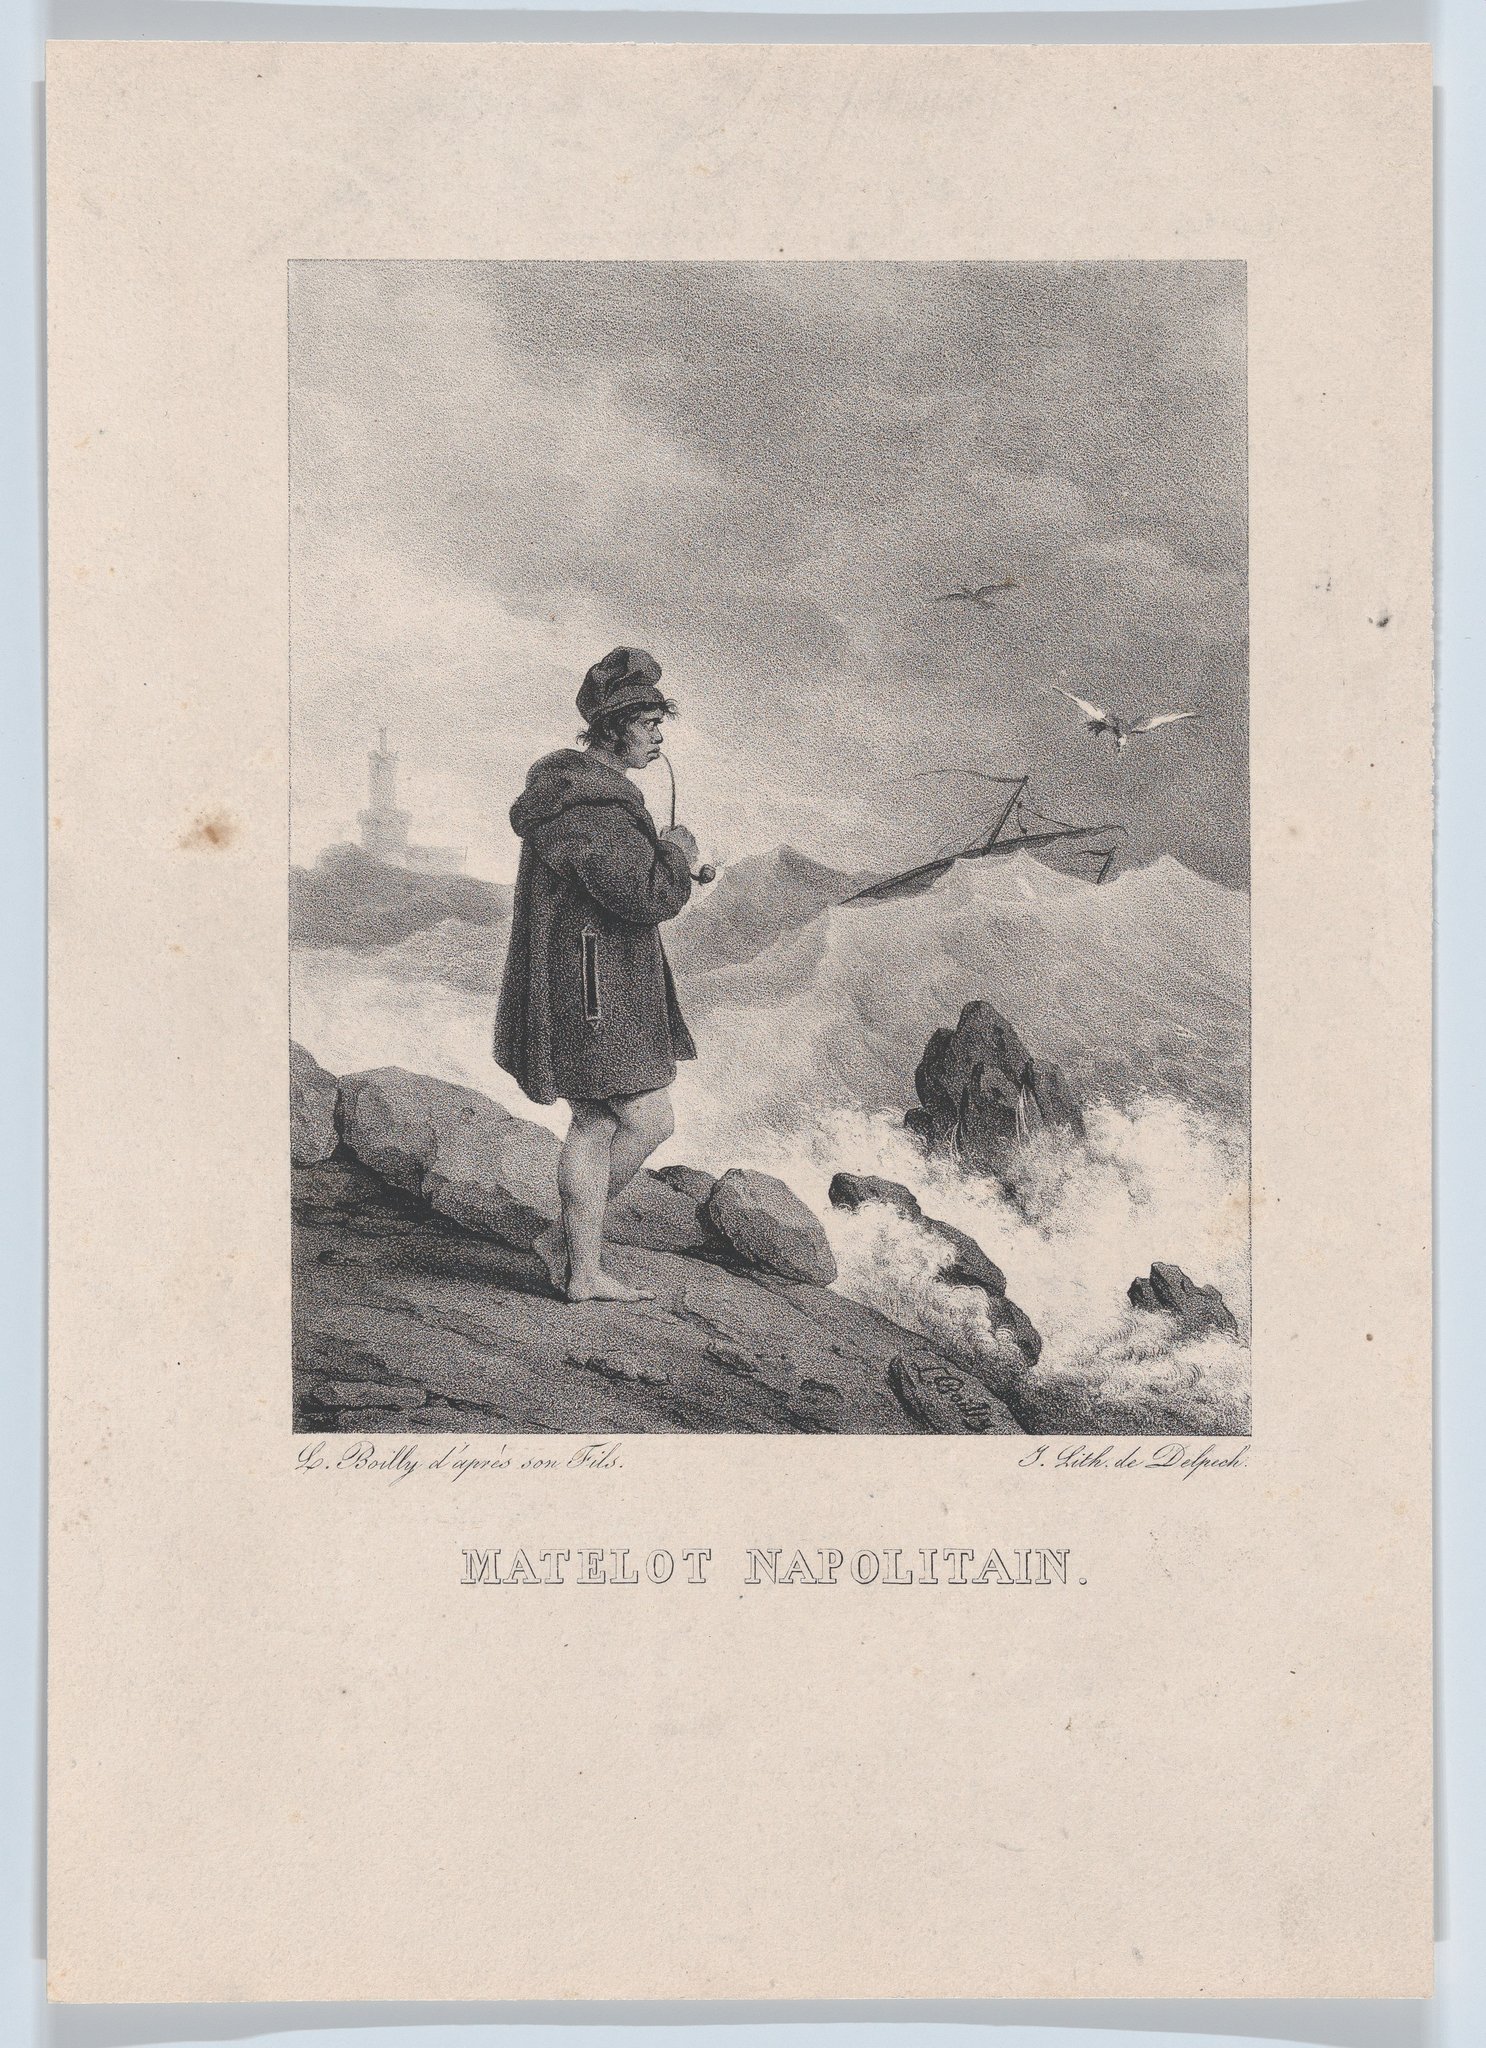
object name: print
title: Neapolitan Sailor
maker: louis léopold boilly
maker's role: artist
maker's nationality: french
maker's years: 1761-1845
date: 1826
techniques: lithograph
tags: men,smoking,waves,sailors,pipes